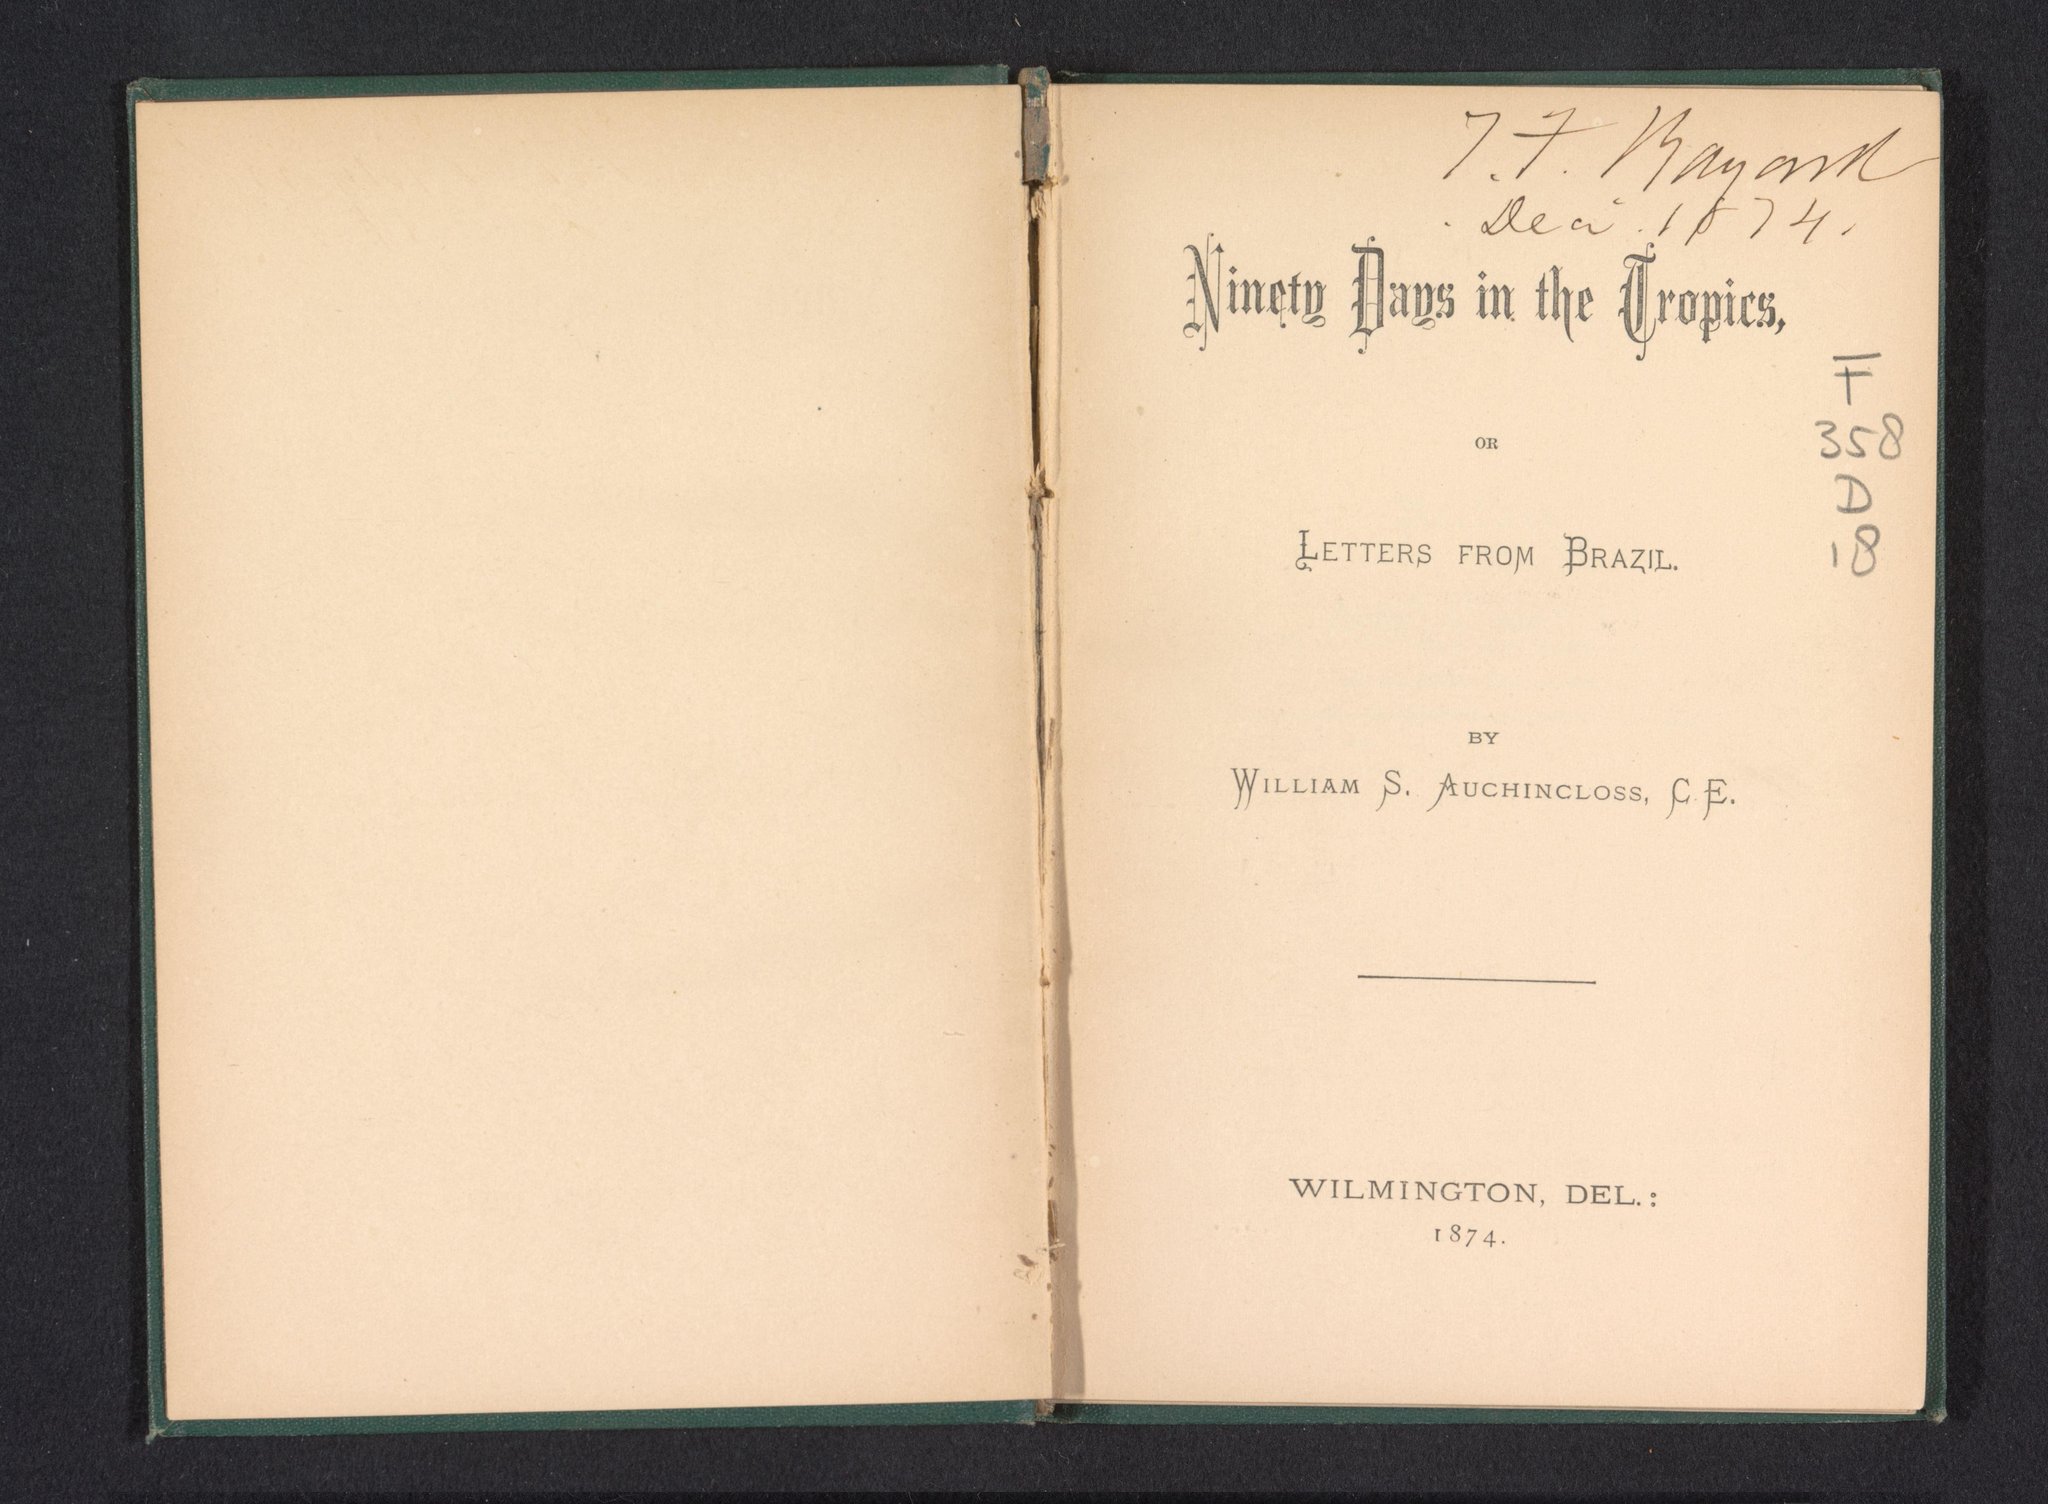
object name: book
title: Ninety days in the tropics, or letters from Brazil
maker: william stuart auchincloss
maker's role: schrijver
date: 1874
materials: cardboard, linen, paper, photographic support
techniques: albumen print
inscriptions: name: ‘J.[...]ayard Dec. 1874.’, name: ‘Compliments of William S. Auchincloss’